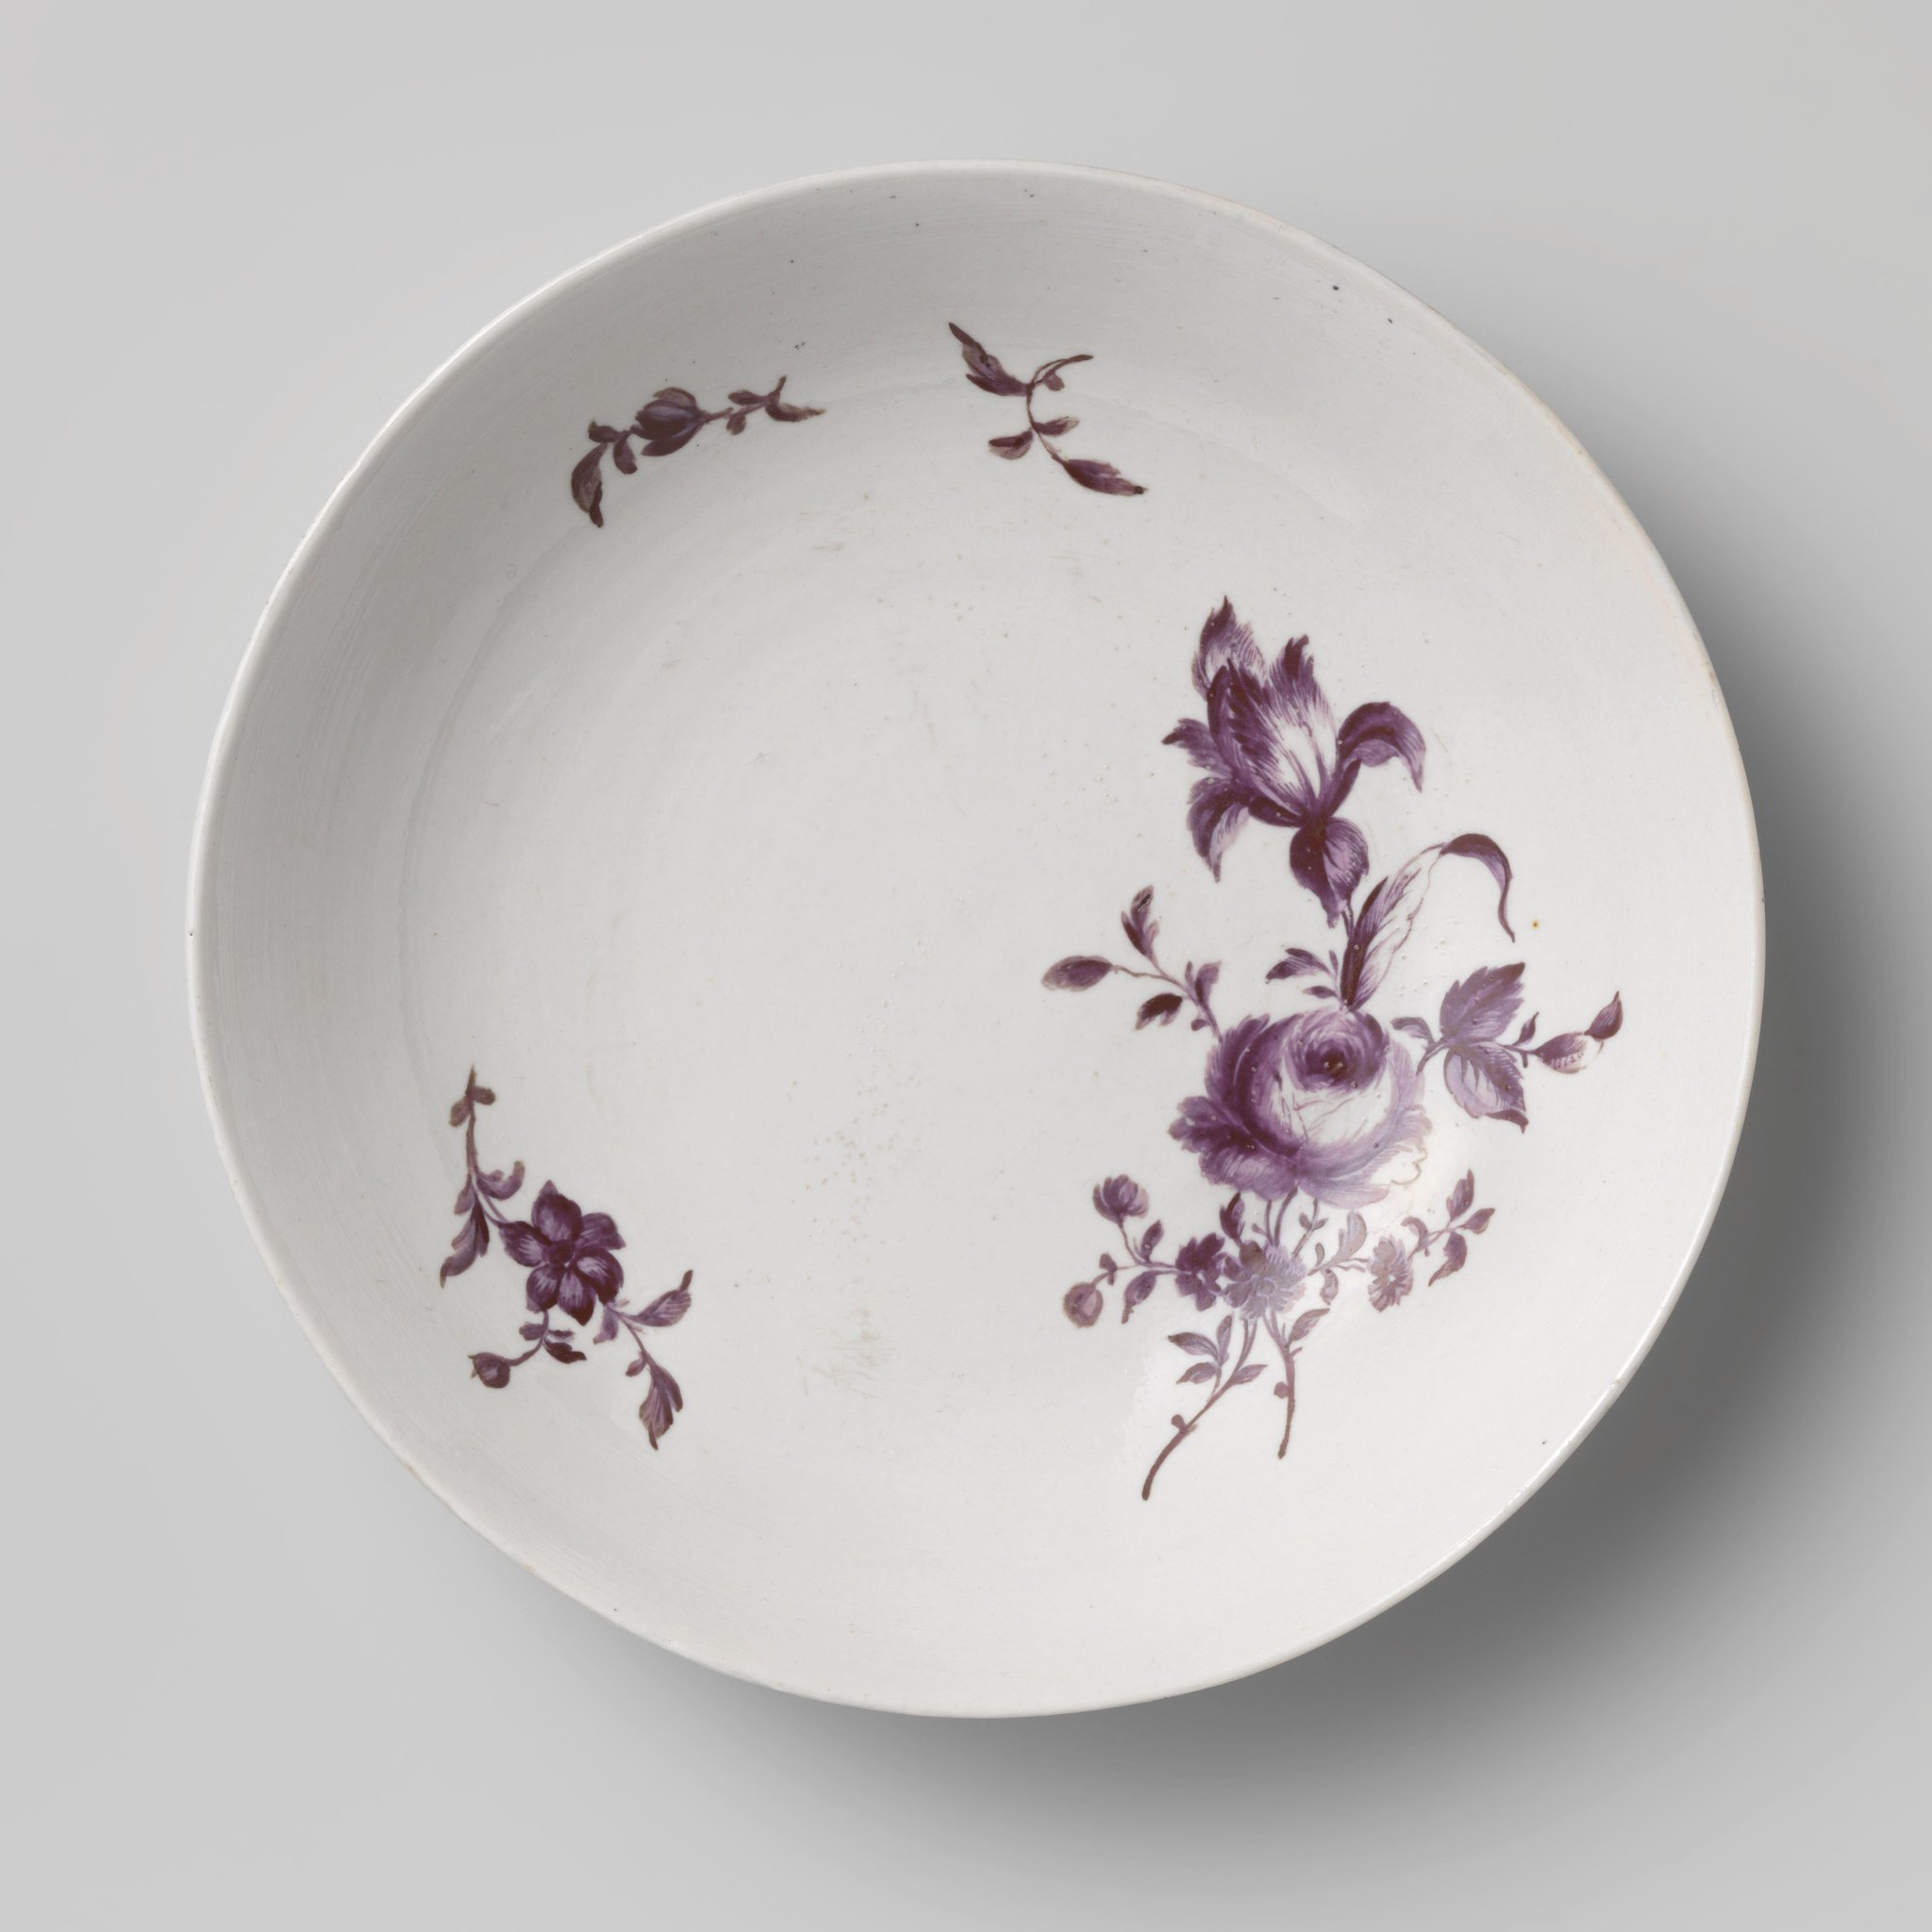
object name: platter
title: Schotel met bloemboeket en strooibloemen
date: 1759-1771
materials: porcelain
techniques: painted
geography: weesp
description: Dish. Porcelain. Weesp, c. 1760 - 1770. Factory of Betram, Count Gronsveld-Diepenbroick.